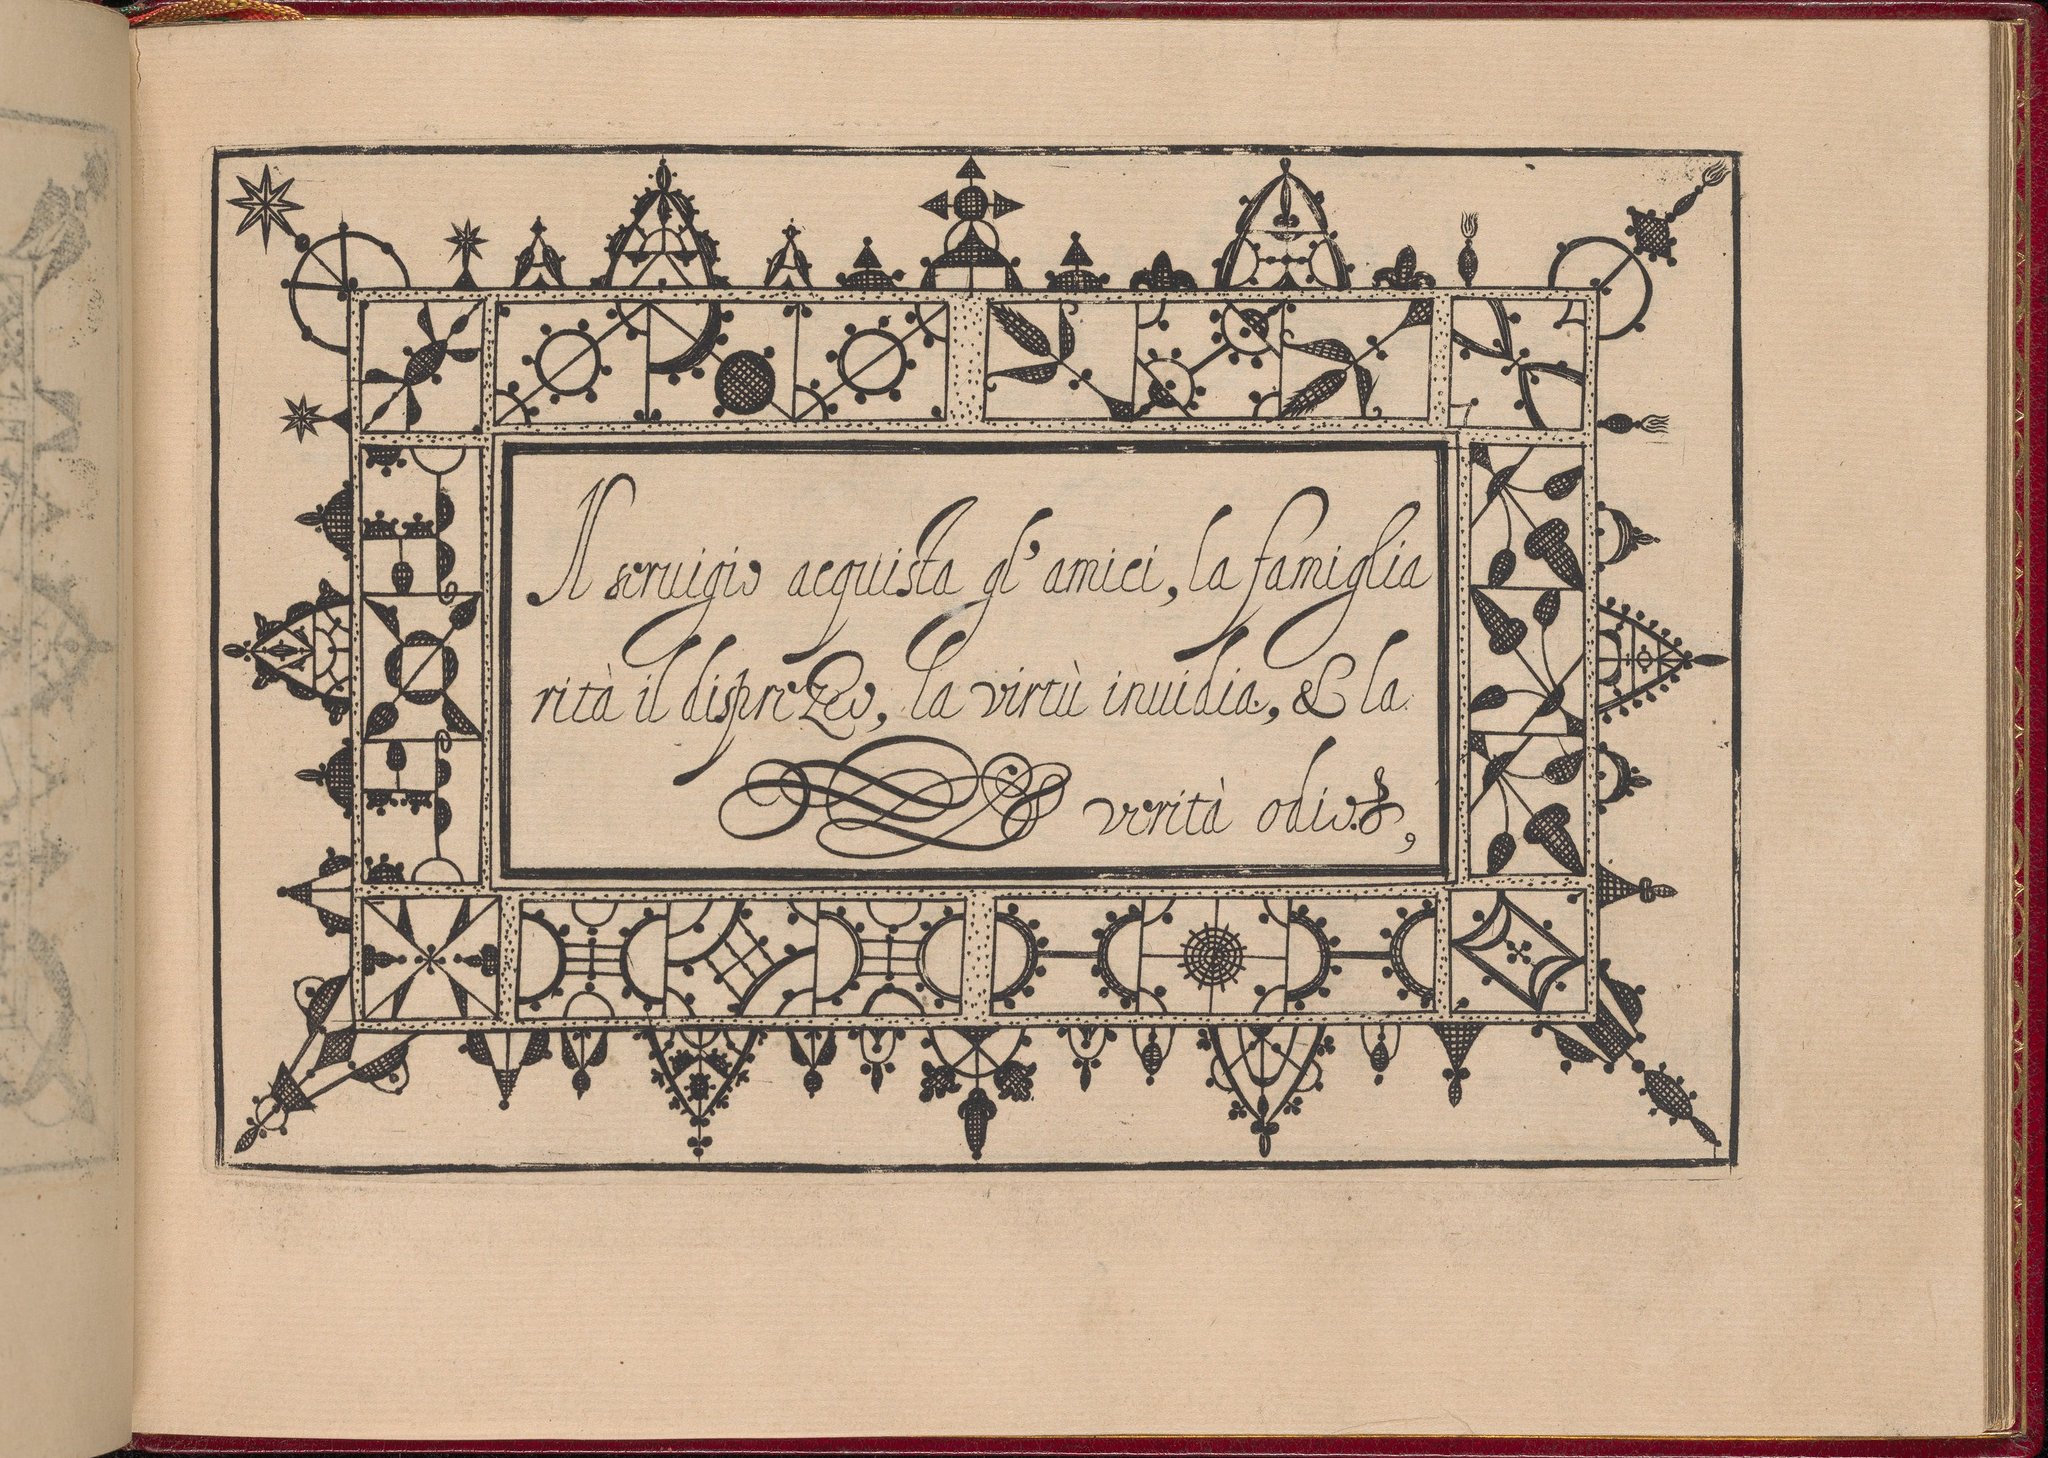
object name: book print ornament architecture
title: Ghirlanda: Di sei vaghi fiori scielti da piu famosi Giardini d'Italia, page 17 (recto)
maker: pietro paulo tozzi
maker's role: designer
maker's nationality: italian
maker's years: 1593-1628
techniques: drawing, etching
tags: ornament